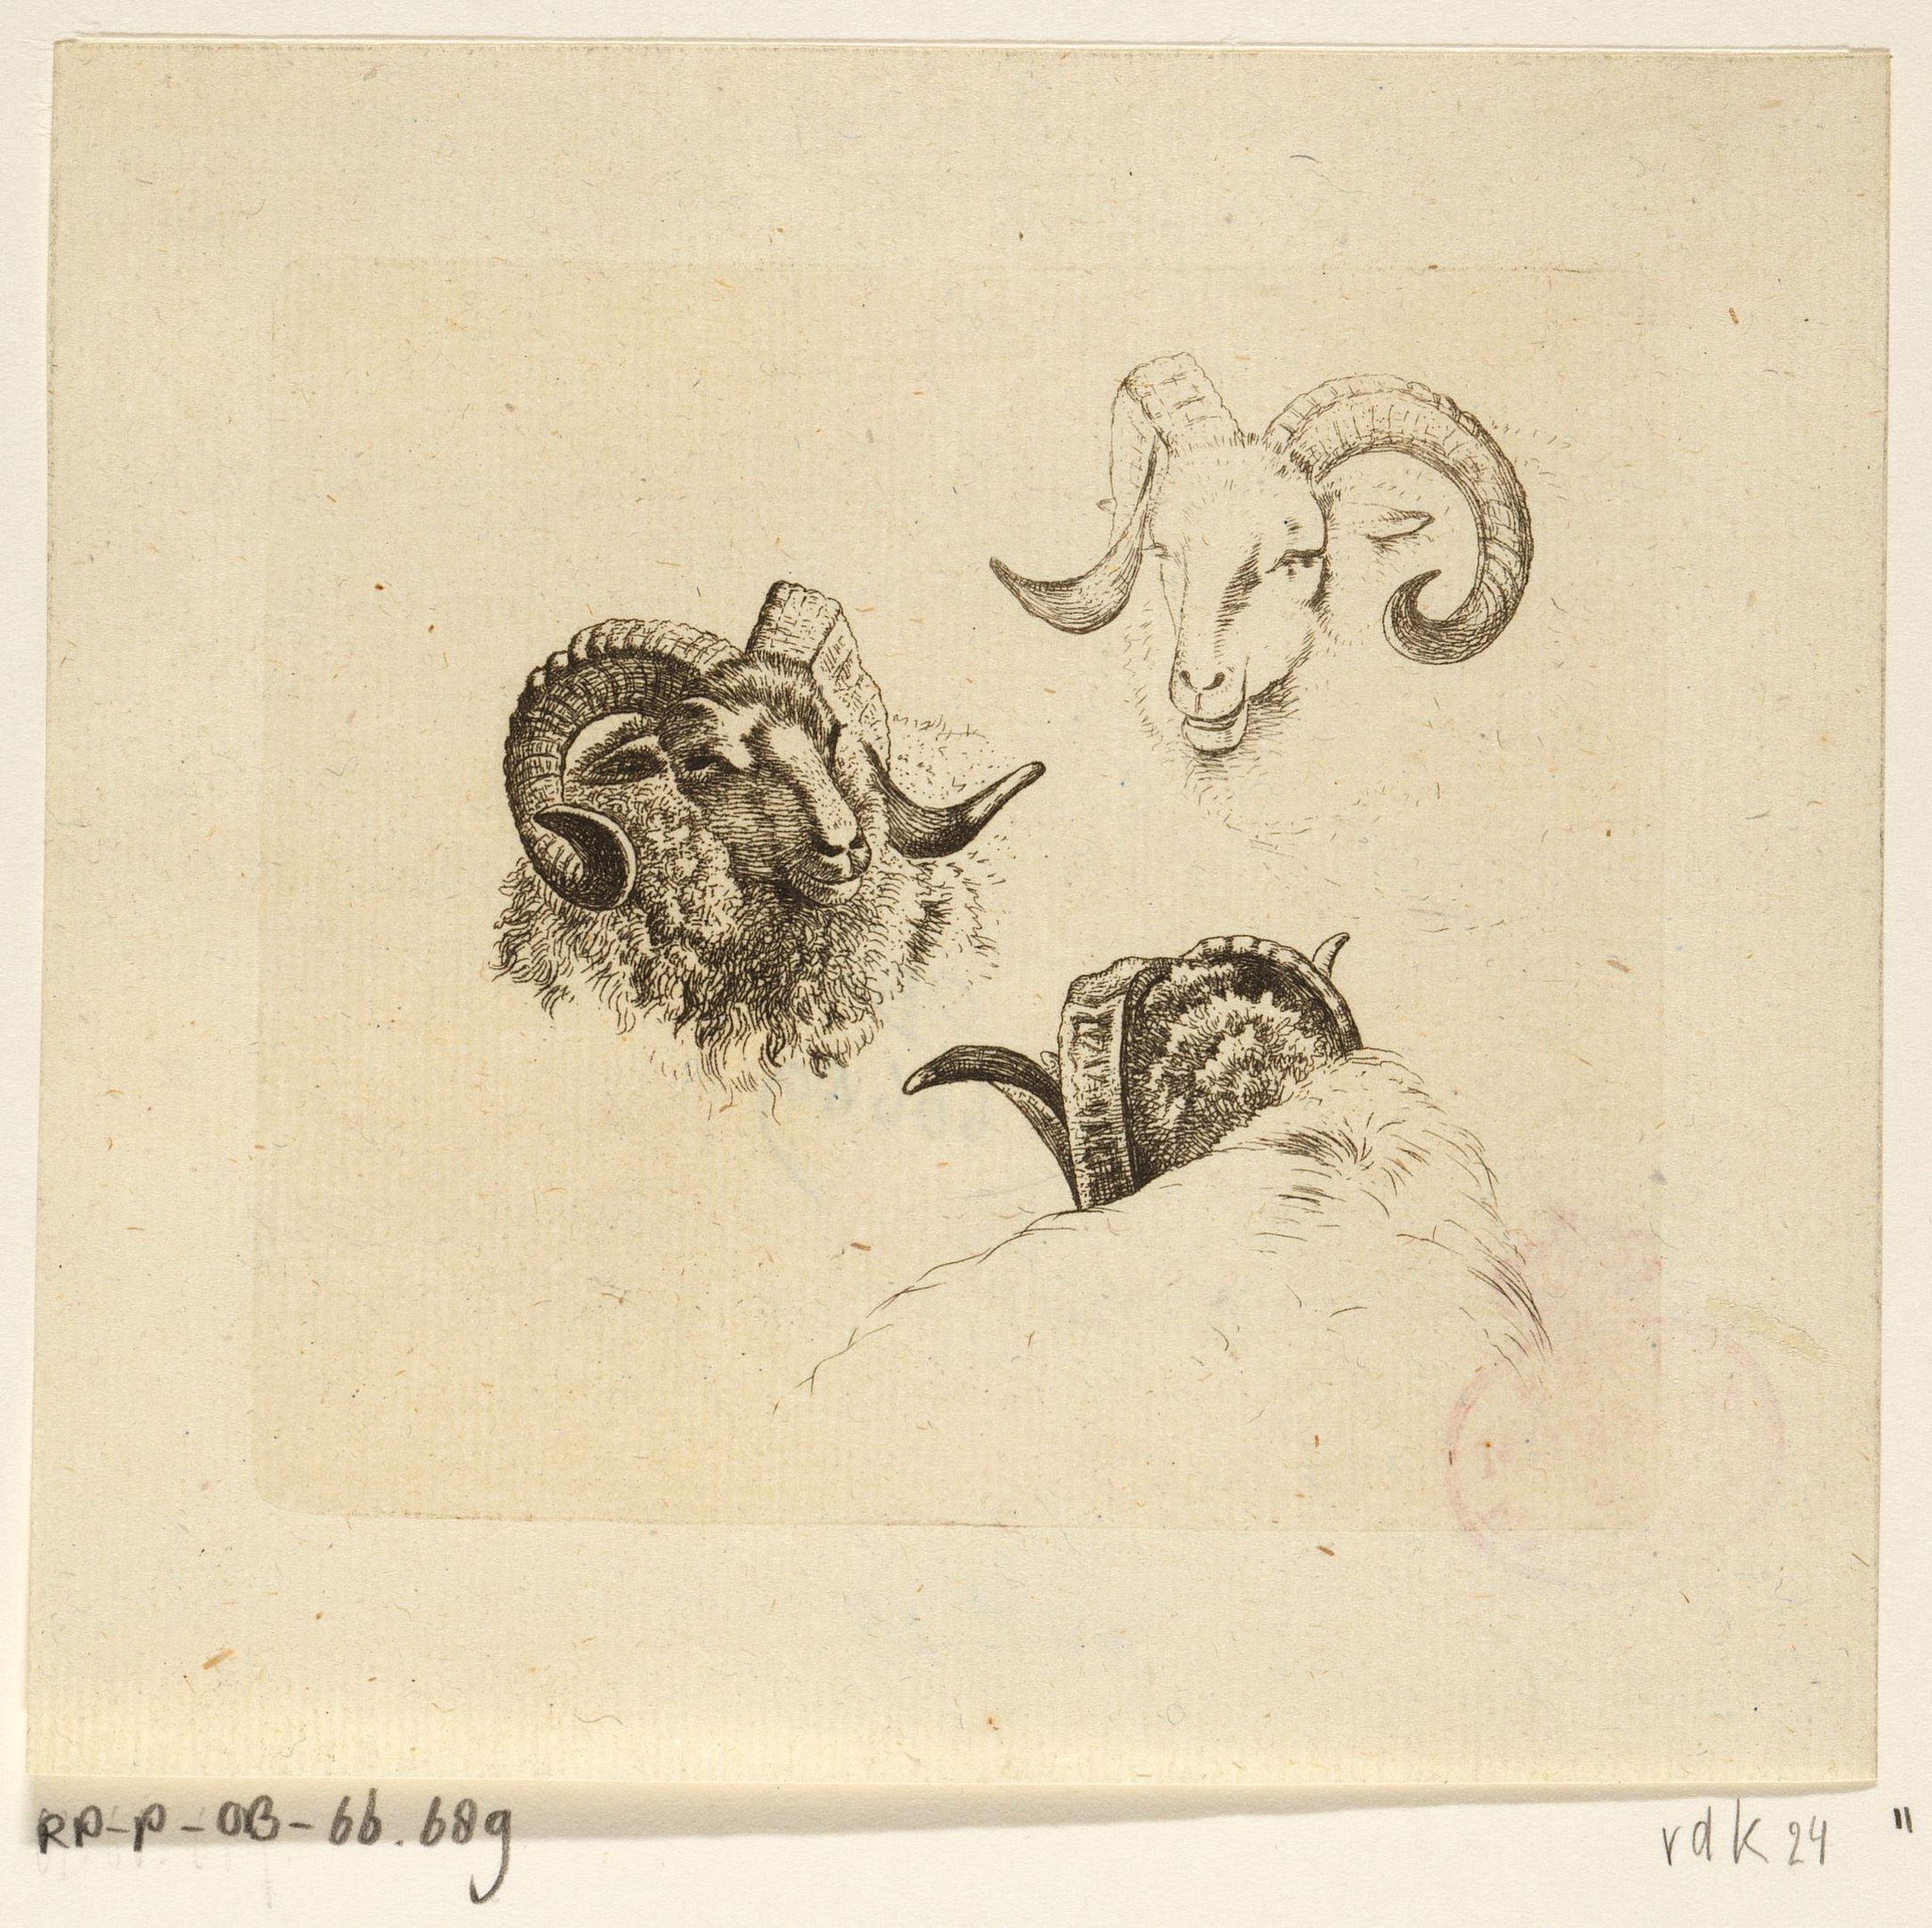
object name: print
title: Drie ramskoppen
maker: wouter johannes van troostwijk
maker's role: draughtsman, painter, print maker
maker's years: 1782-1810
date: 1792-1810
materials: paper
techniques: etching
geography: amsterdam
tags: ram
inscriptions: collector's mark: Lugt 12